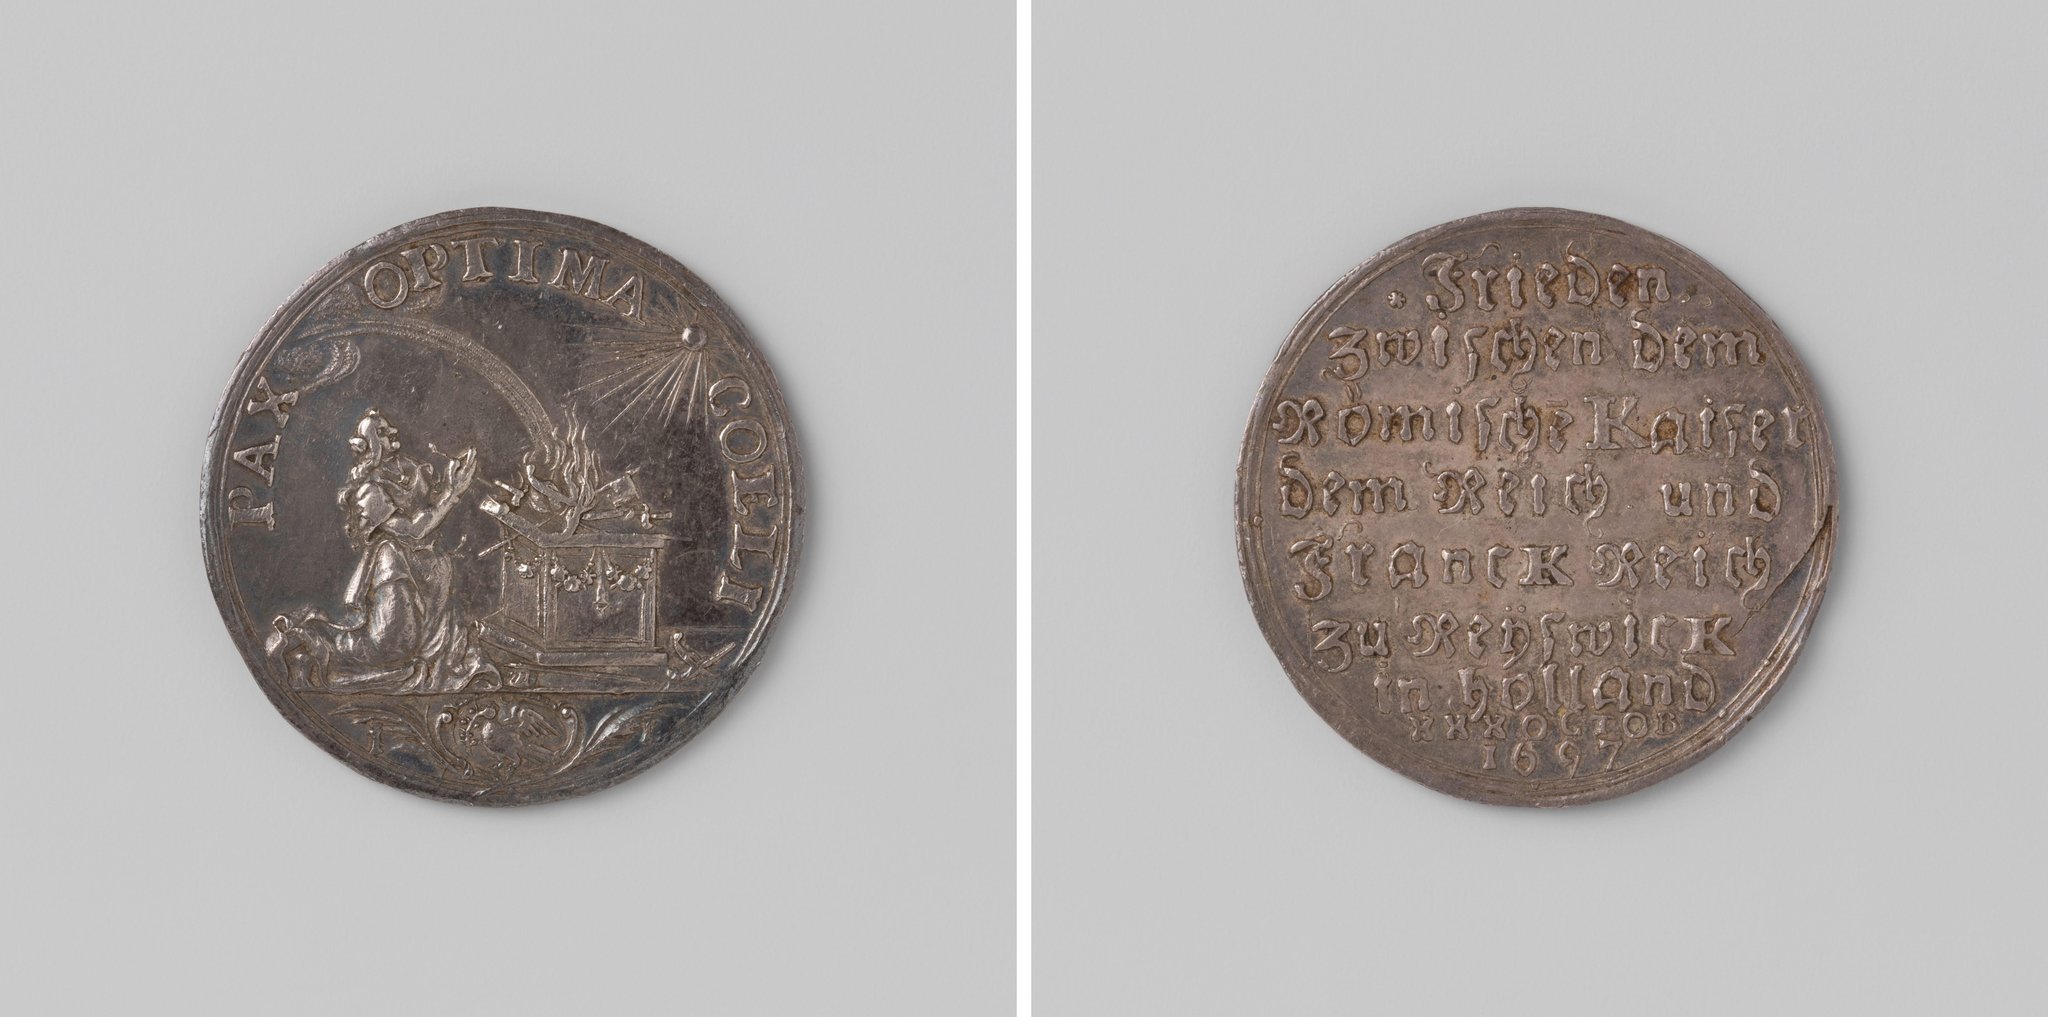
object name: medal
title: Vrede van Rijswijk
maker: johann linck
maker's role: print maker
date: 1697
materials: silver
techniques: striking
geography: germany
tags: rijswijk, vrede van rijswijk (1697)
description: Zilveren penning. Voorzijde: knielende man voor altaar waarop krijgstuig wordt verbrand binnen omschrift; afsnede: vogel binnen siermotief. Keerzijde: opschrift